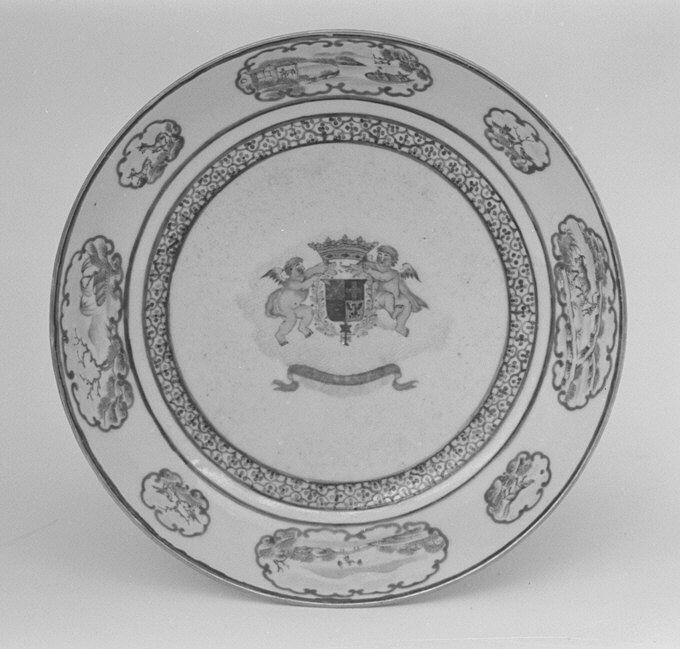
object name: saucer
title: Saucer (part of a service)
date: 1800-1805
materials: hard paste porcelain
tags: coat of arms